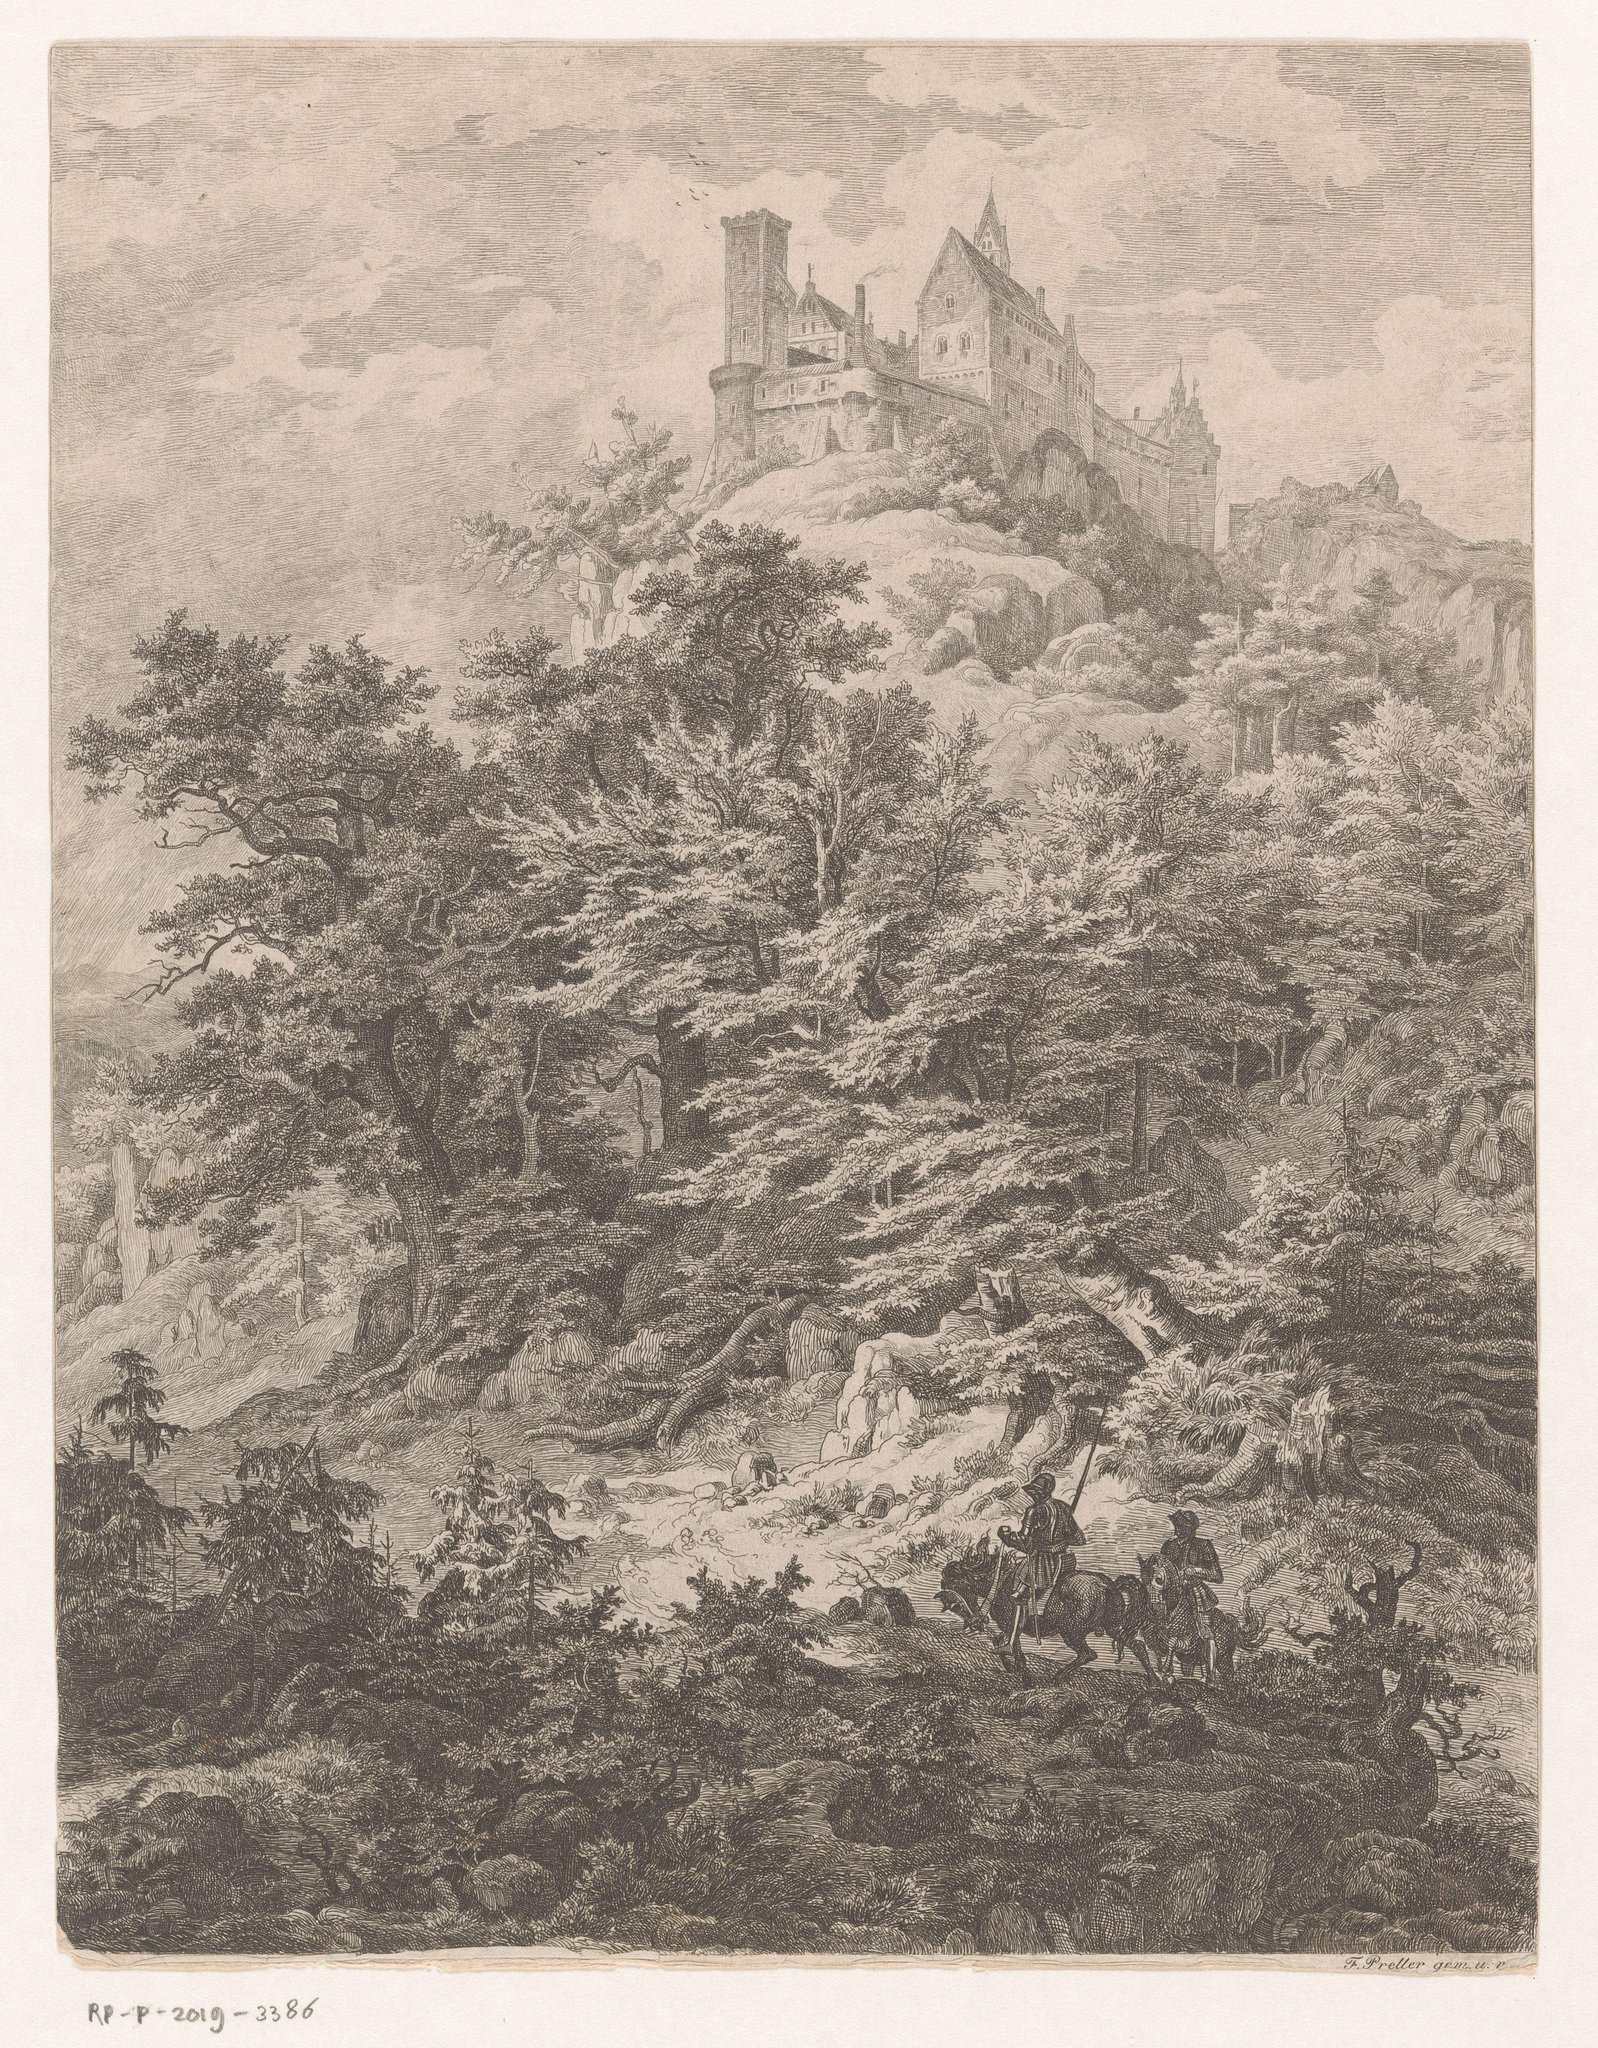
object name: print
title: Twee ridders nabij kasteel Wartburg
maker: friedrich preller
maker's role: painter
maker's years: 1804-1878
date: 1814-1899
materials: paper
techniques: etching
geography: germany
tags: fortress, castle, knight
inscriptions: collector's mark: Lugt 2228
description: De titel in de ondermarge is bij deze afdruk afgeknipt.